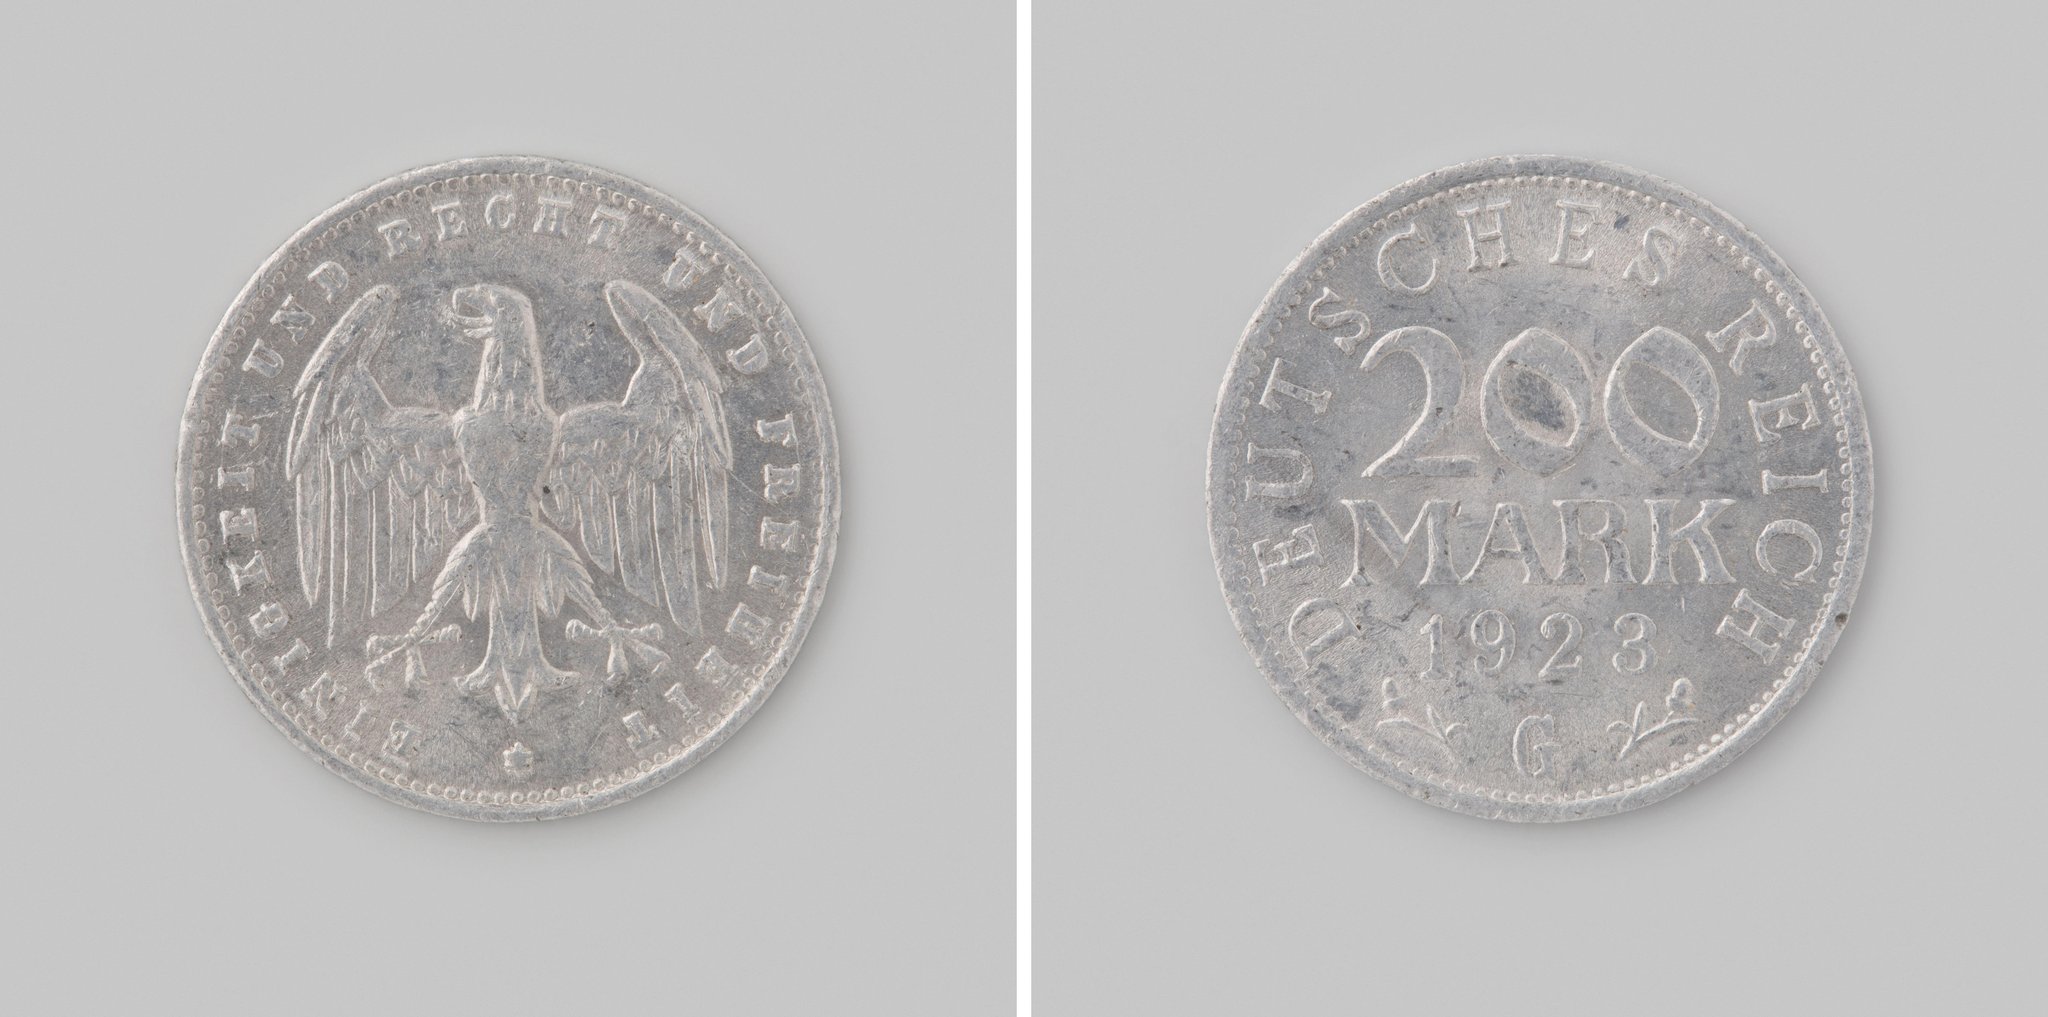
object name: coin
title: 200 mark uit Duitsland,1923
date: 1923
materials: aluminum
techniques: striking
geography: karlsruhe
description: Aluminium munt. Voorzijde: enkelkoppige adelaar. Keerzijde: waarde-aanduiding in twee regels, waaronder jaartal. Daaronder letter G. Kartelrand.